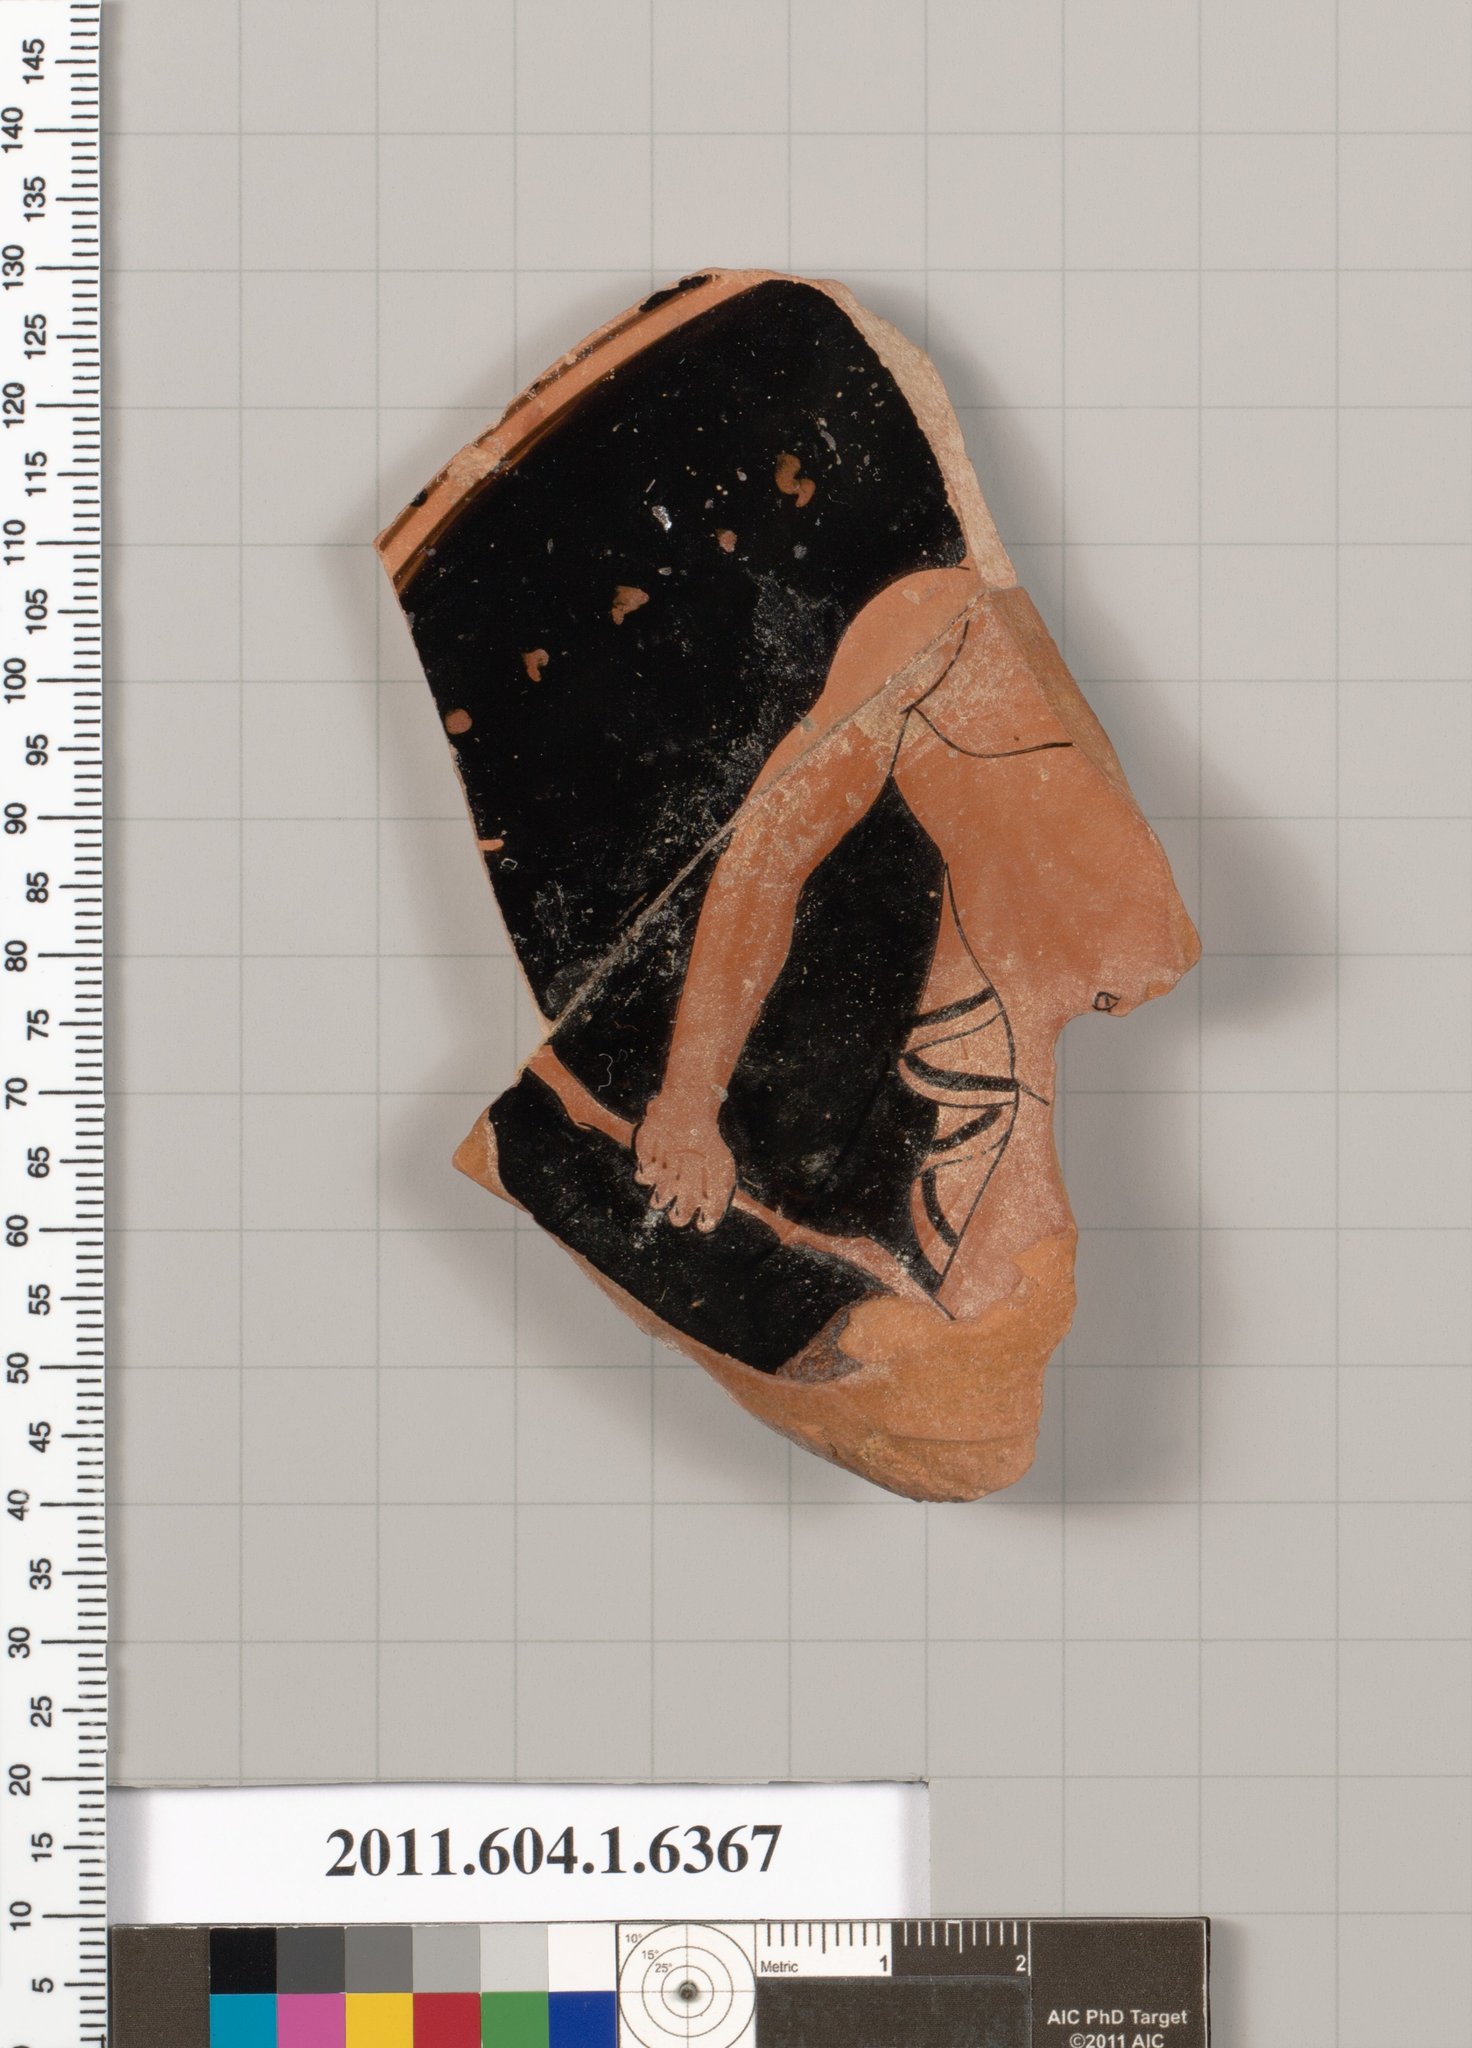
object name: kylix fragment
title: Terracotta fragment of a kylix (drinking cup)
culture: greek, attic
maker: antiphon painter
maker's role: artist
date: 490-480 BCE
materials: terracotta